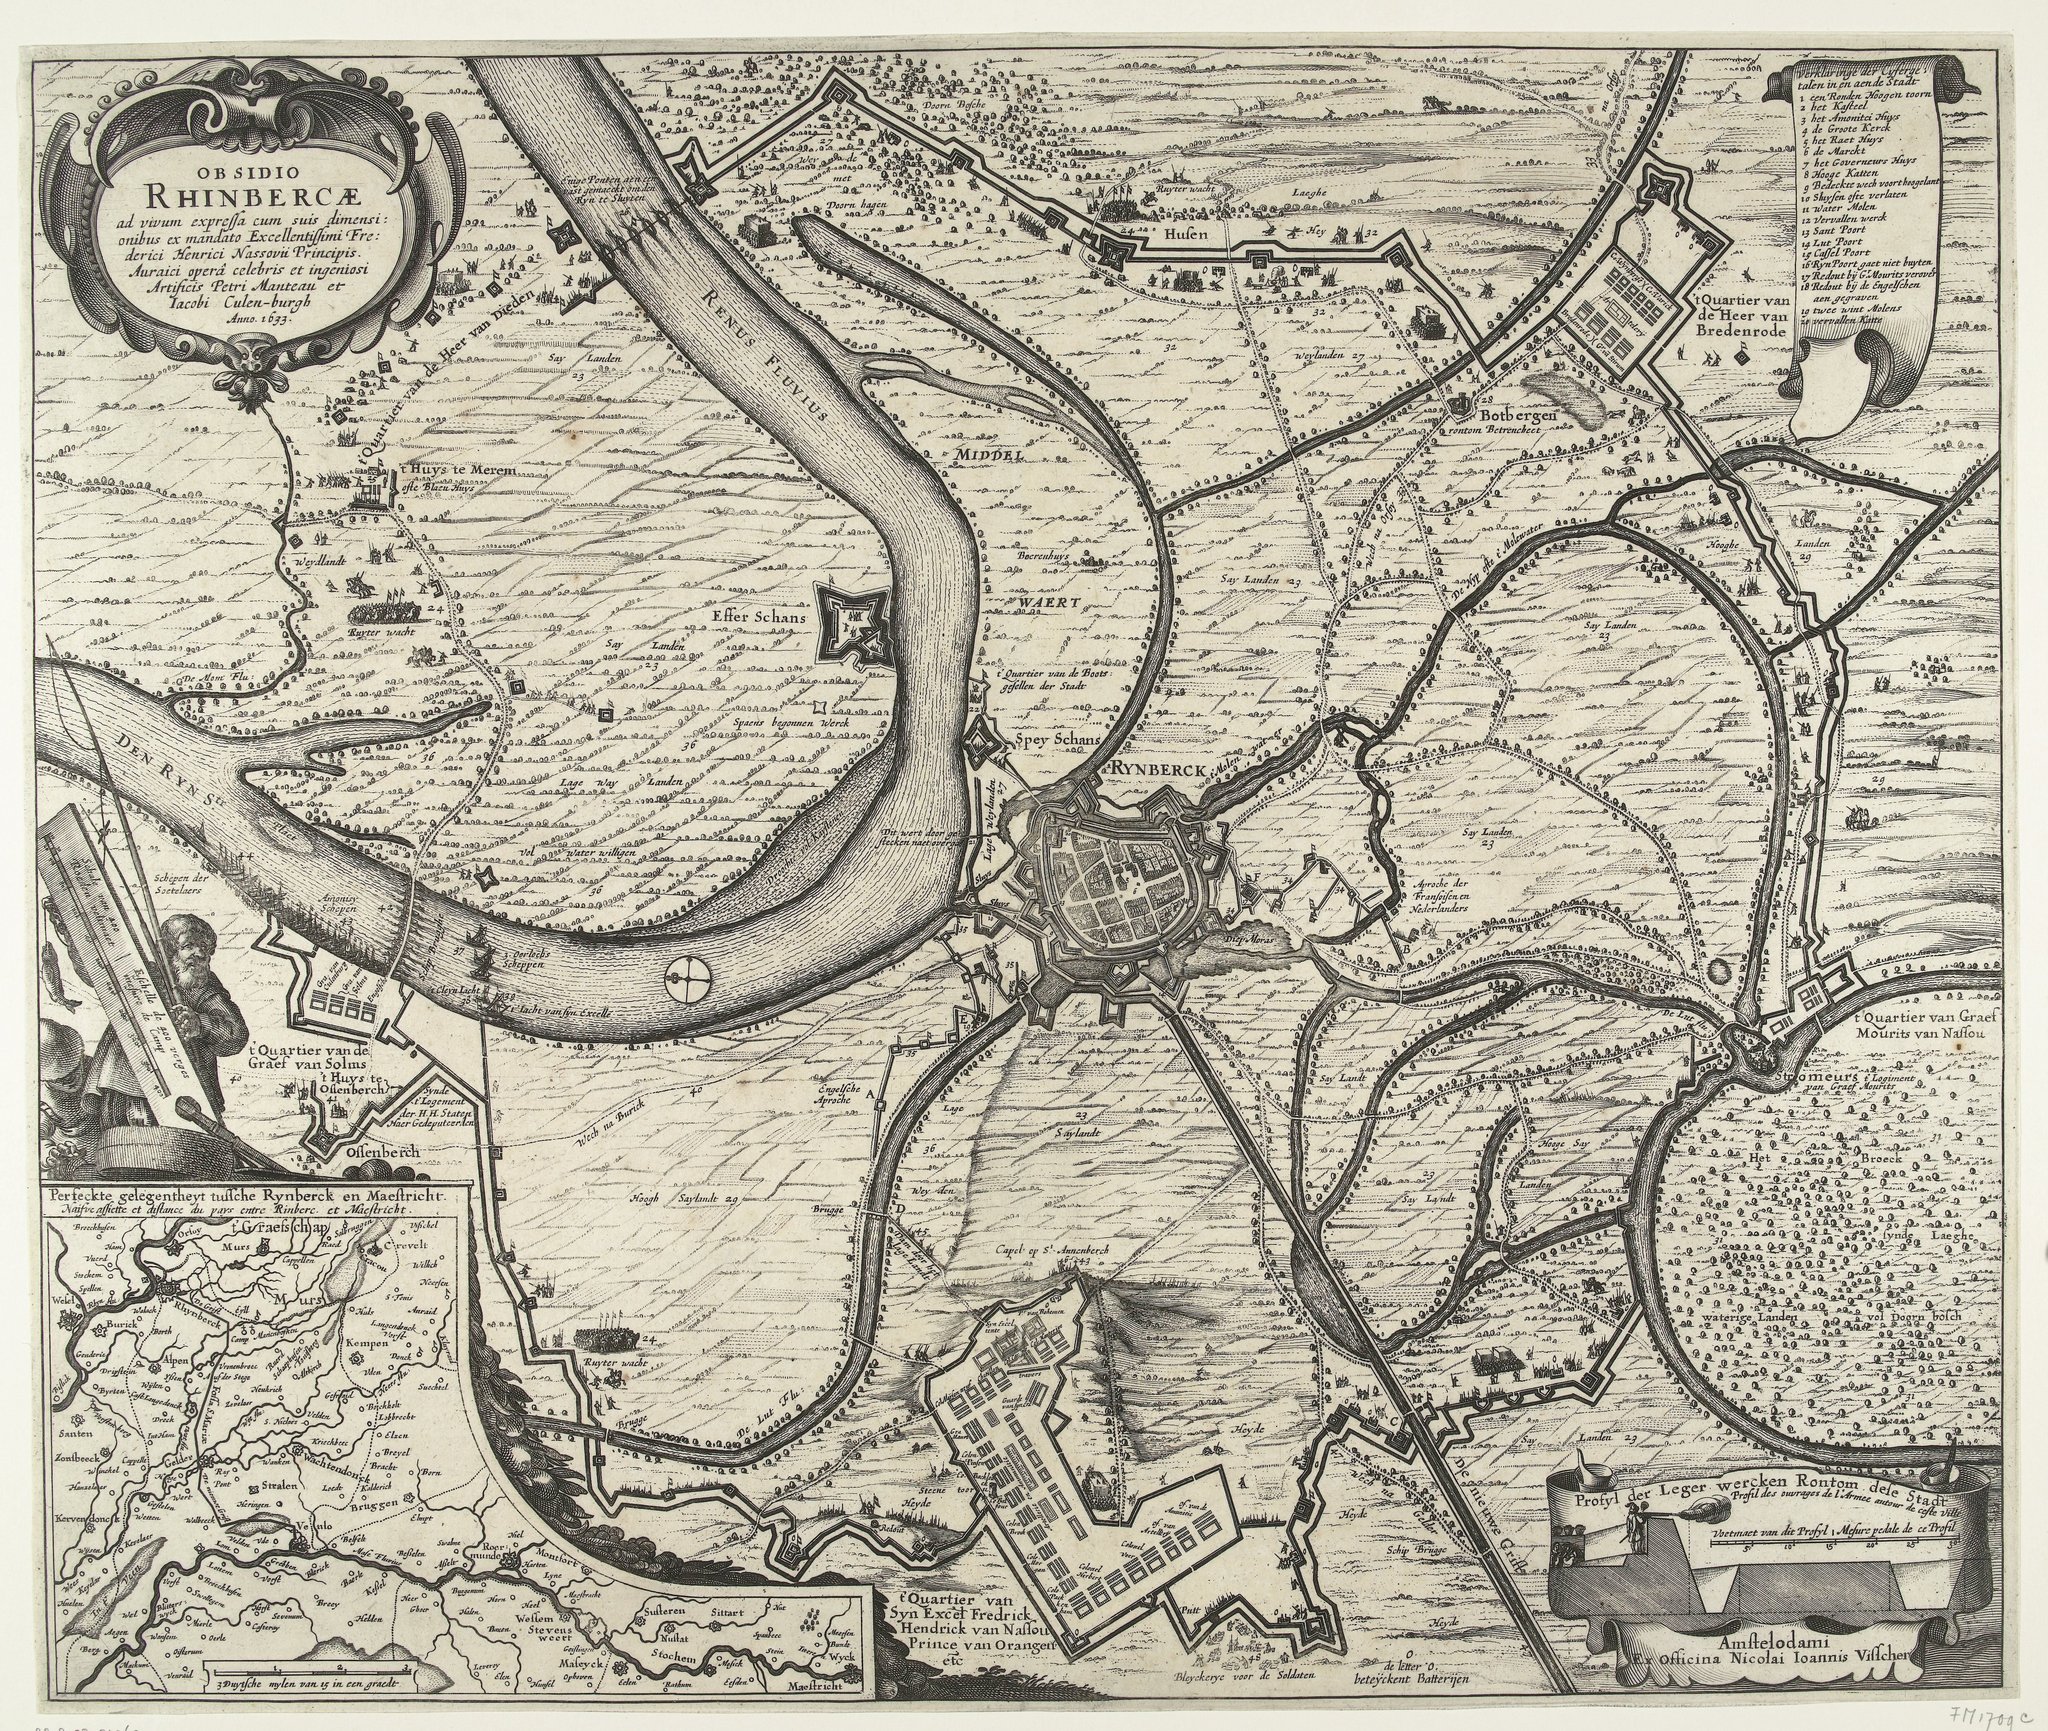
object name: print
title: Obsidio Rhinbercae ad vivum expressa (...) Frederici Henrici Nassovii Principis Auraici opera celebris et ingeniosi Artificis Petri Manteau et Jacobi Culen-burgh Anno 1633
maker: claes jansz. visscher (ii)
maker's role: draughtsman, print maker, publisher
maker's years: 1586-1652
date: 1633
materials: paper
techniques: engraving, etching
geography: amsterdam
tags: delft, the hague, frederick henry (prince of orange), maps of separate countries or regions, siege, position war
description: Kaart van het beleg en de verovering van Rijnberg door het Staatse leger onder Frederik Hendrik, 16 mei - 2 juni 1633. Centraal de stad Rijnberg aan de Rijn, onderaan het kwartier van de stadhouder. Rechtsboven een banderol met de legenda 1-20 in het Nederlands. Linksonder een inzet met een kaartje van het gebied tussen Rijnberg en Maastricht met randwerk met vissers. Onbedrukt op achterzijde.